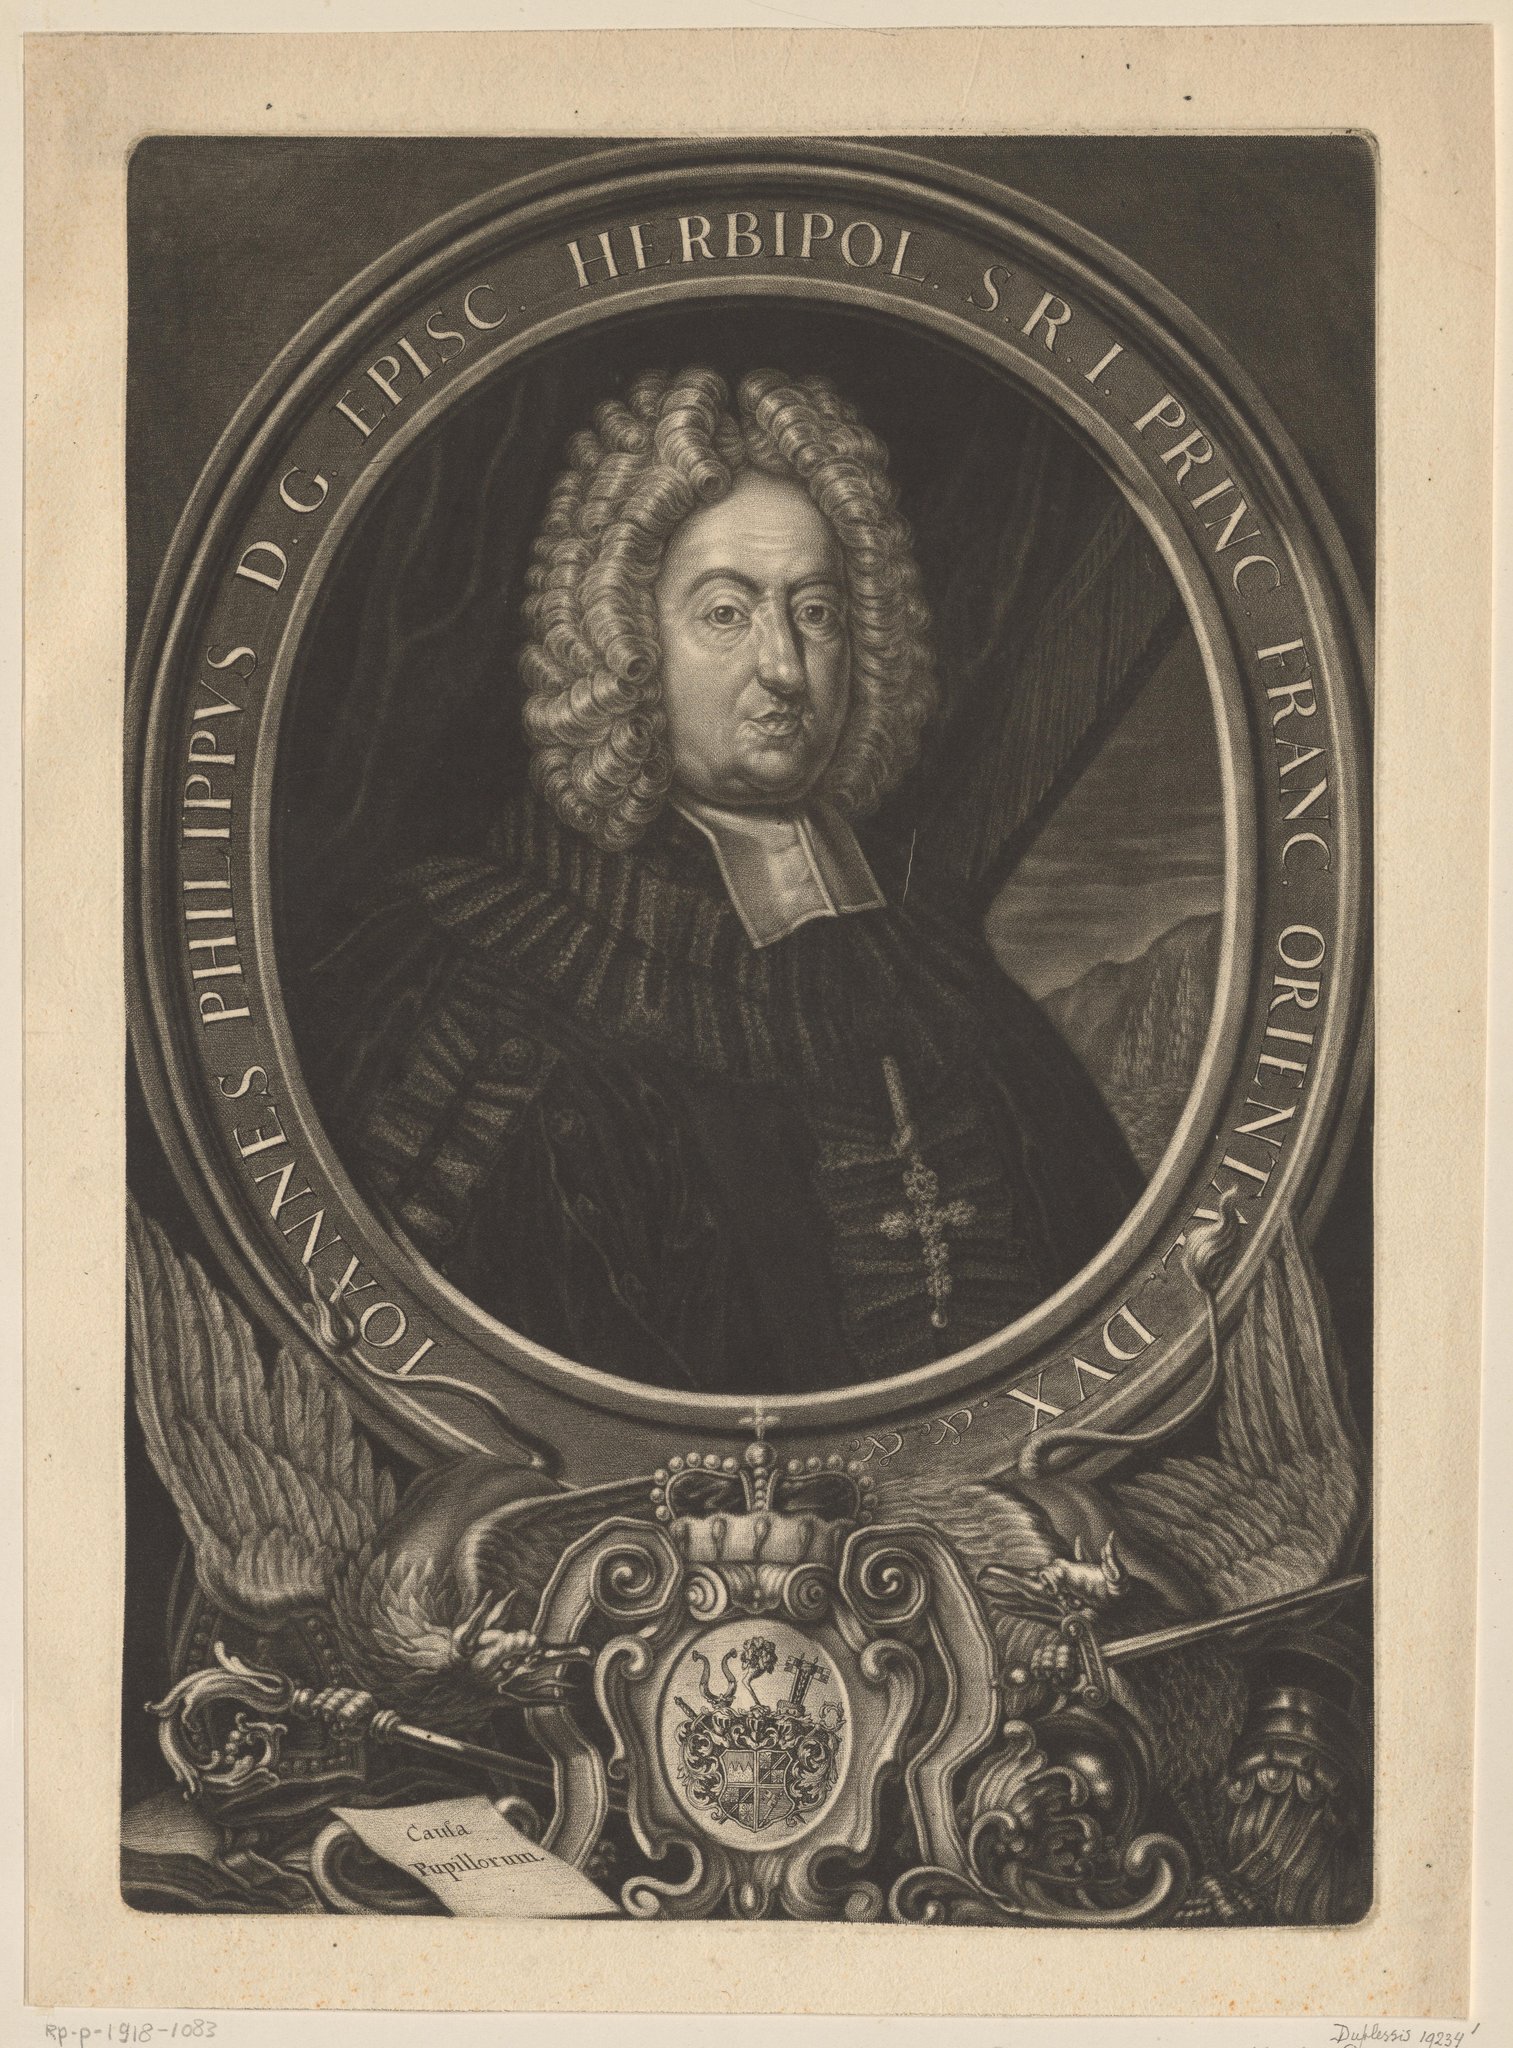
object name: print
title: Portret van Johann Philipp von Greifenclau zu Vollraths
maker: Anonymous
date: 1700-1800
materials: paper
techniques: mezzotint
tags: theologian, historical persons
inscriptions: collector's mark: Lugt 2233